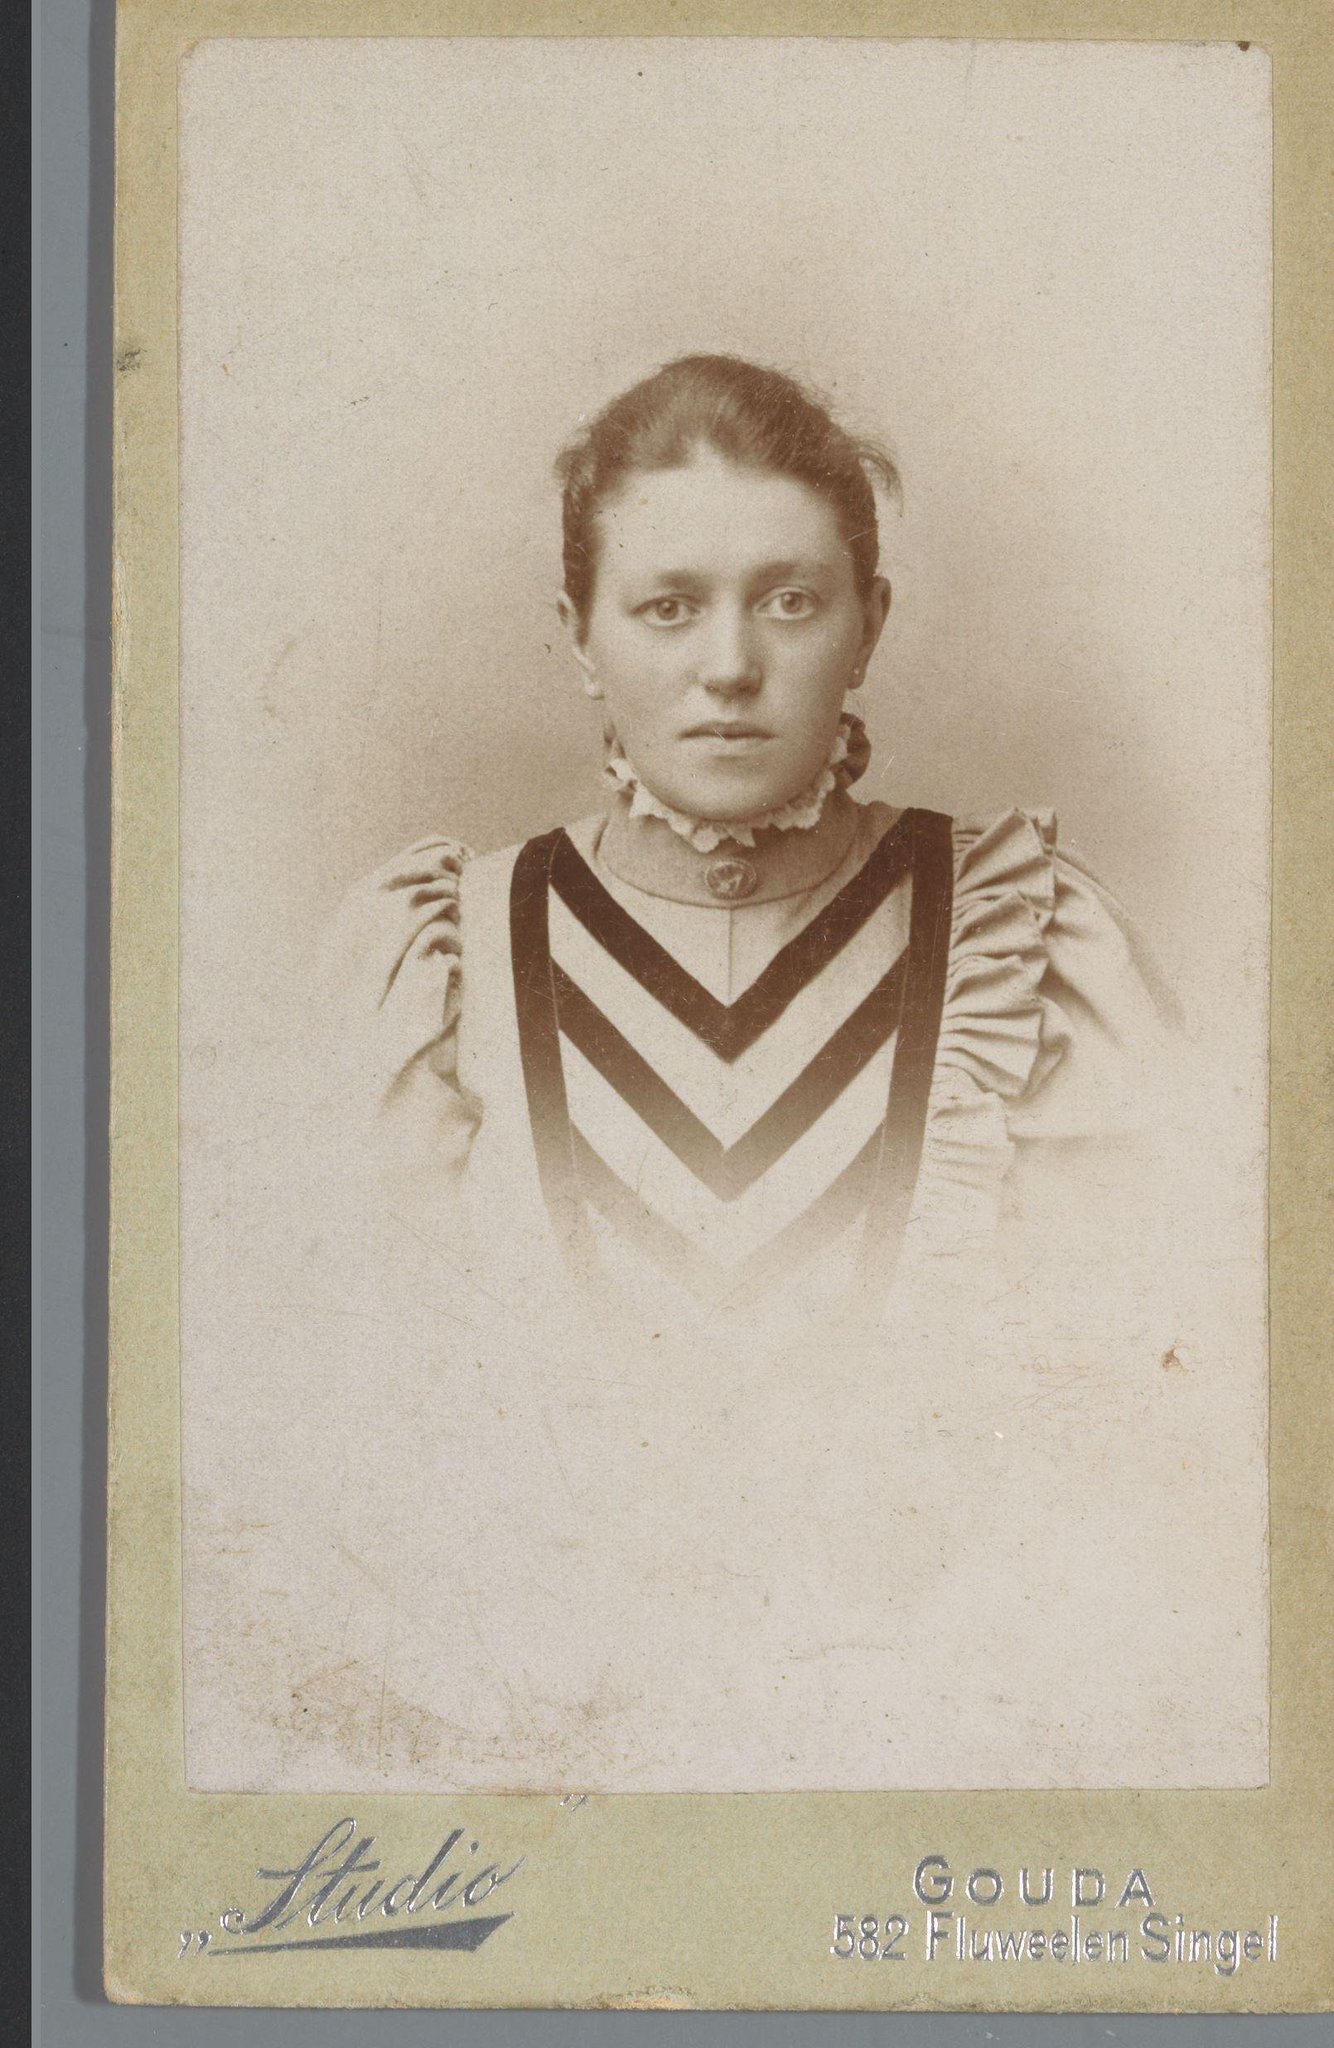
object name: carte de visite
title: Portret van een onbekende vrouw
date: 1880-1920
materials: cardboard, photographic support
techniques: gelatin silver print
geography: gouda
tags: historical persons - bb - woman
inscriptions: inscription: ‘"Studio" GOUDA/ 582 Fluweelen Singel’